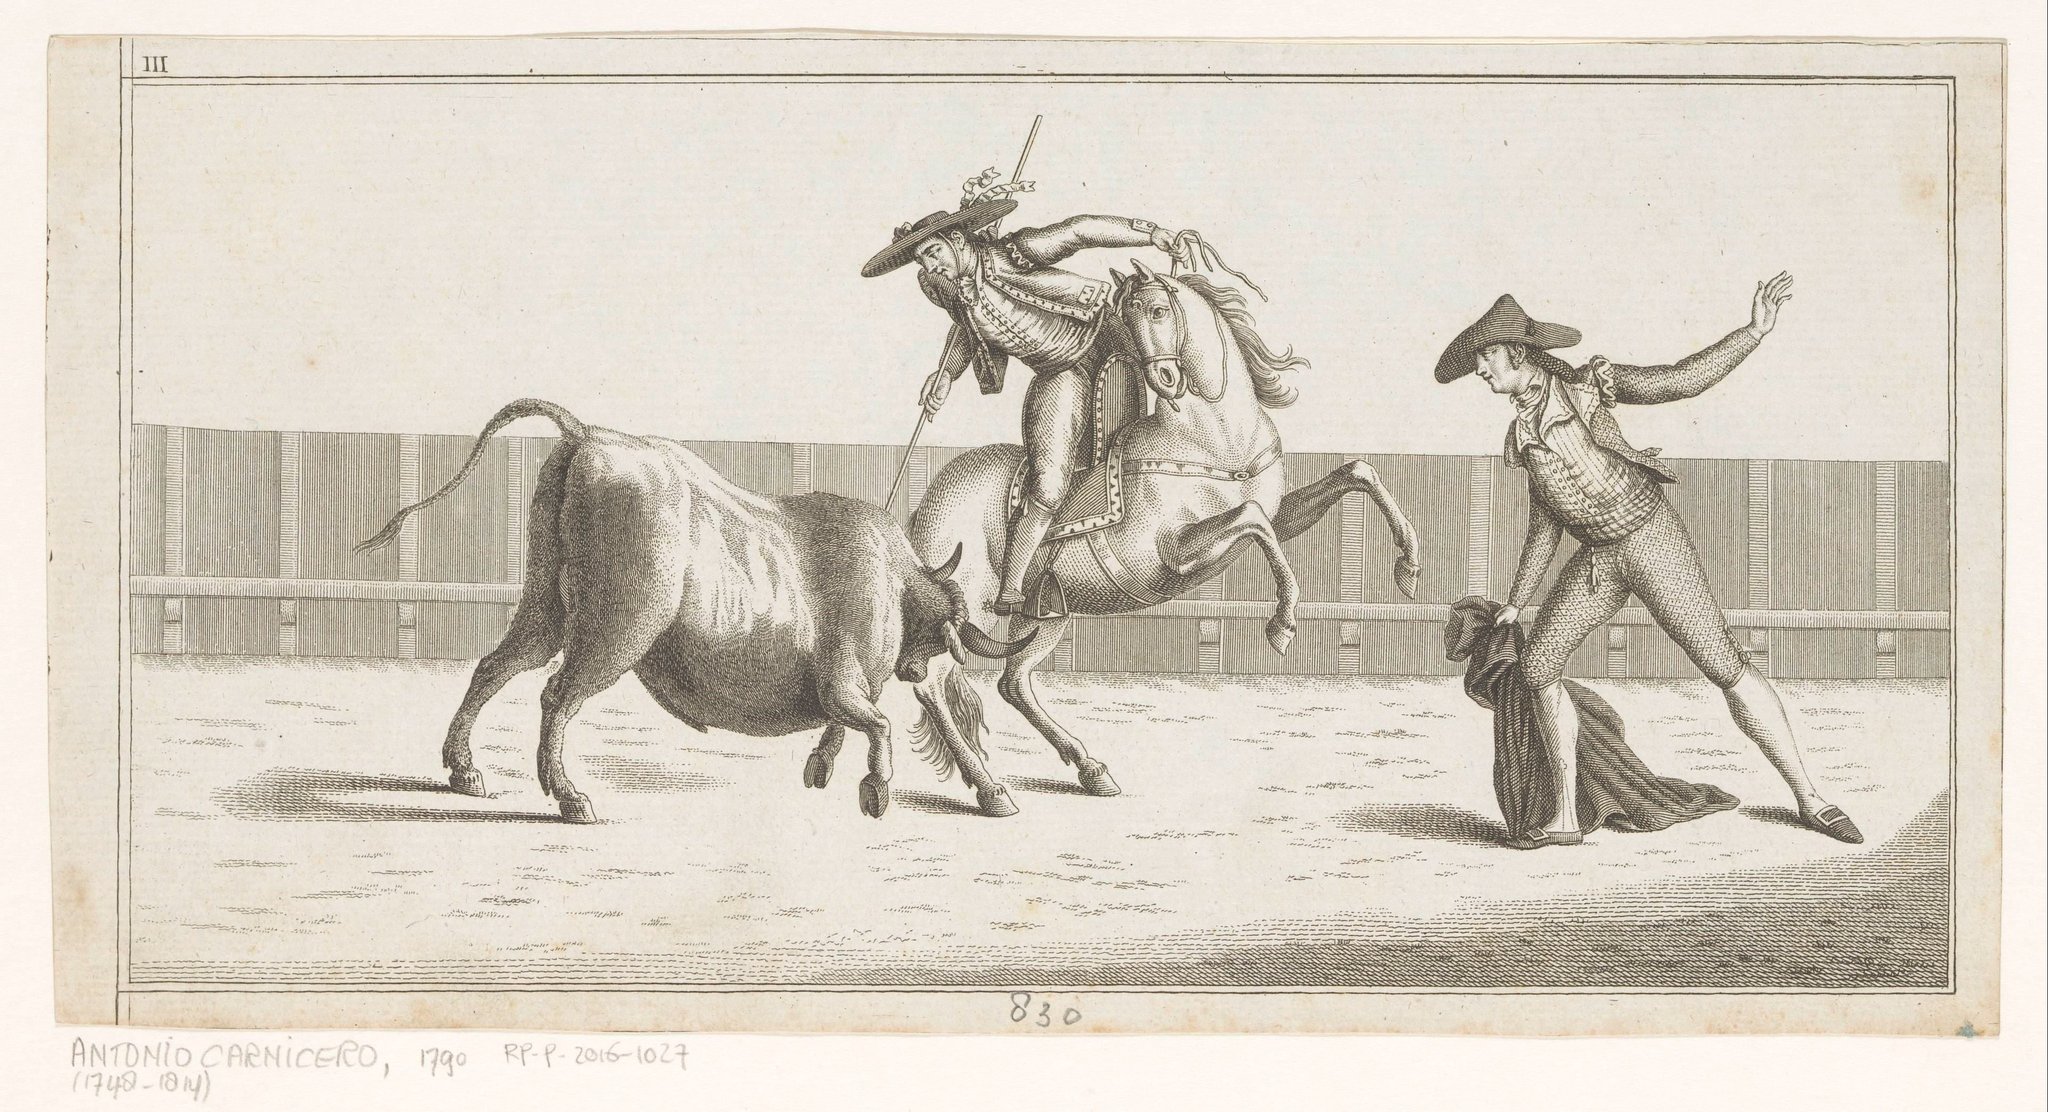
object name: print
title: Verzameling van de belangrijkste manoeuvres bij het stierenvechten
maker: Anonymous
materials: paper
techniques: etching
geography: spain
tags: bullfight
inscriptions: collector's mark: Lugt 2228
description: Deze prent maakt deel uit van een serie, bestaande uit twaalf prenten met voorstellingen van stierenvechten. Het betreft anonieme kopieën naar de serie door Antonio Carnicero.